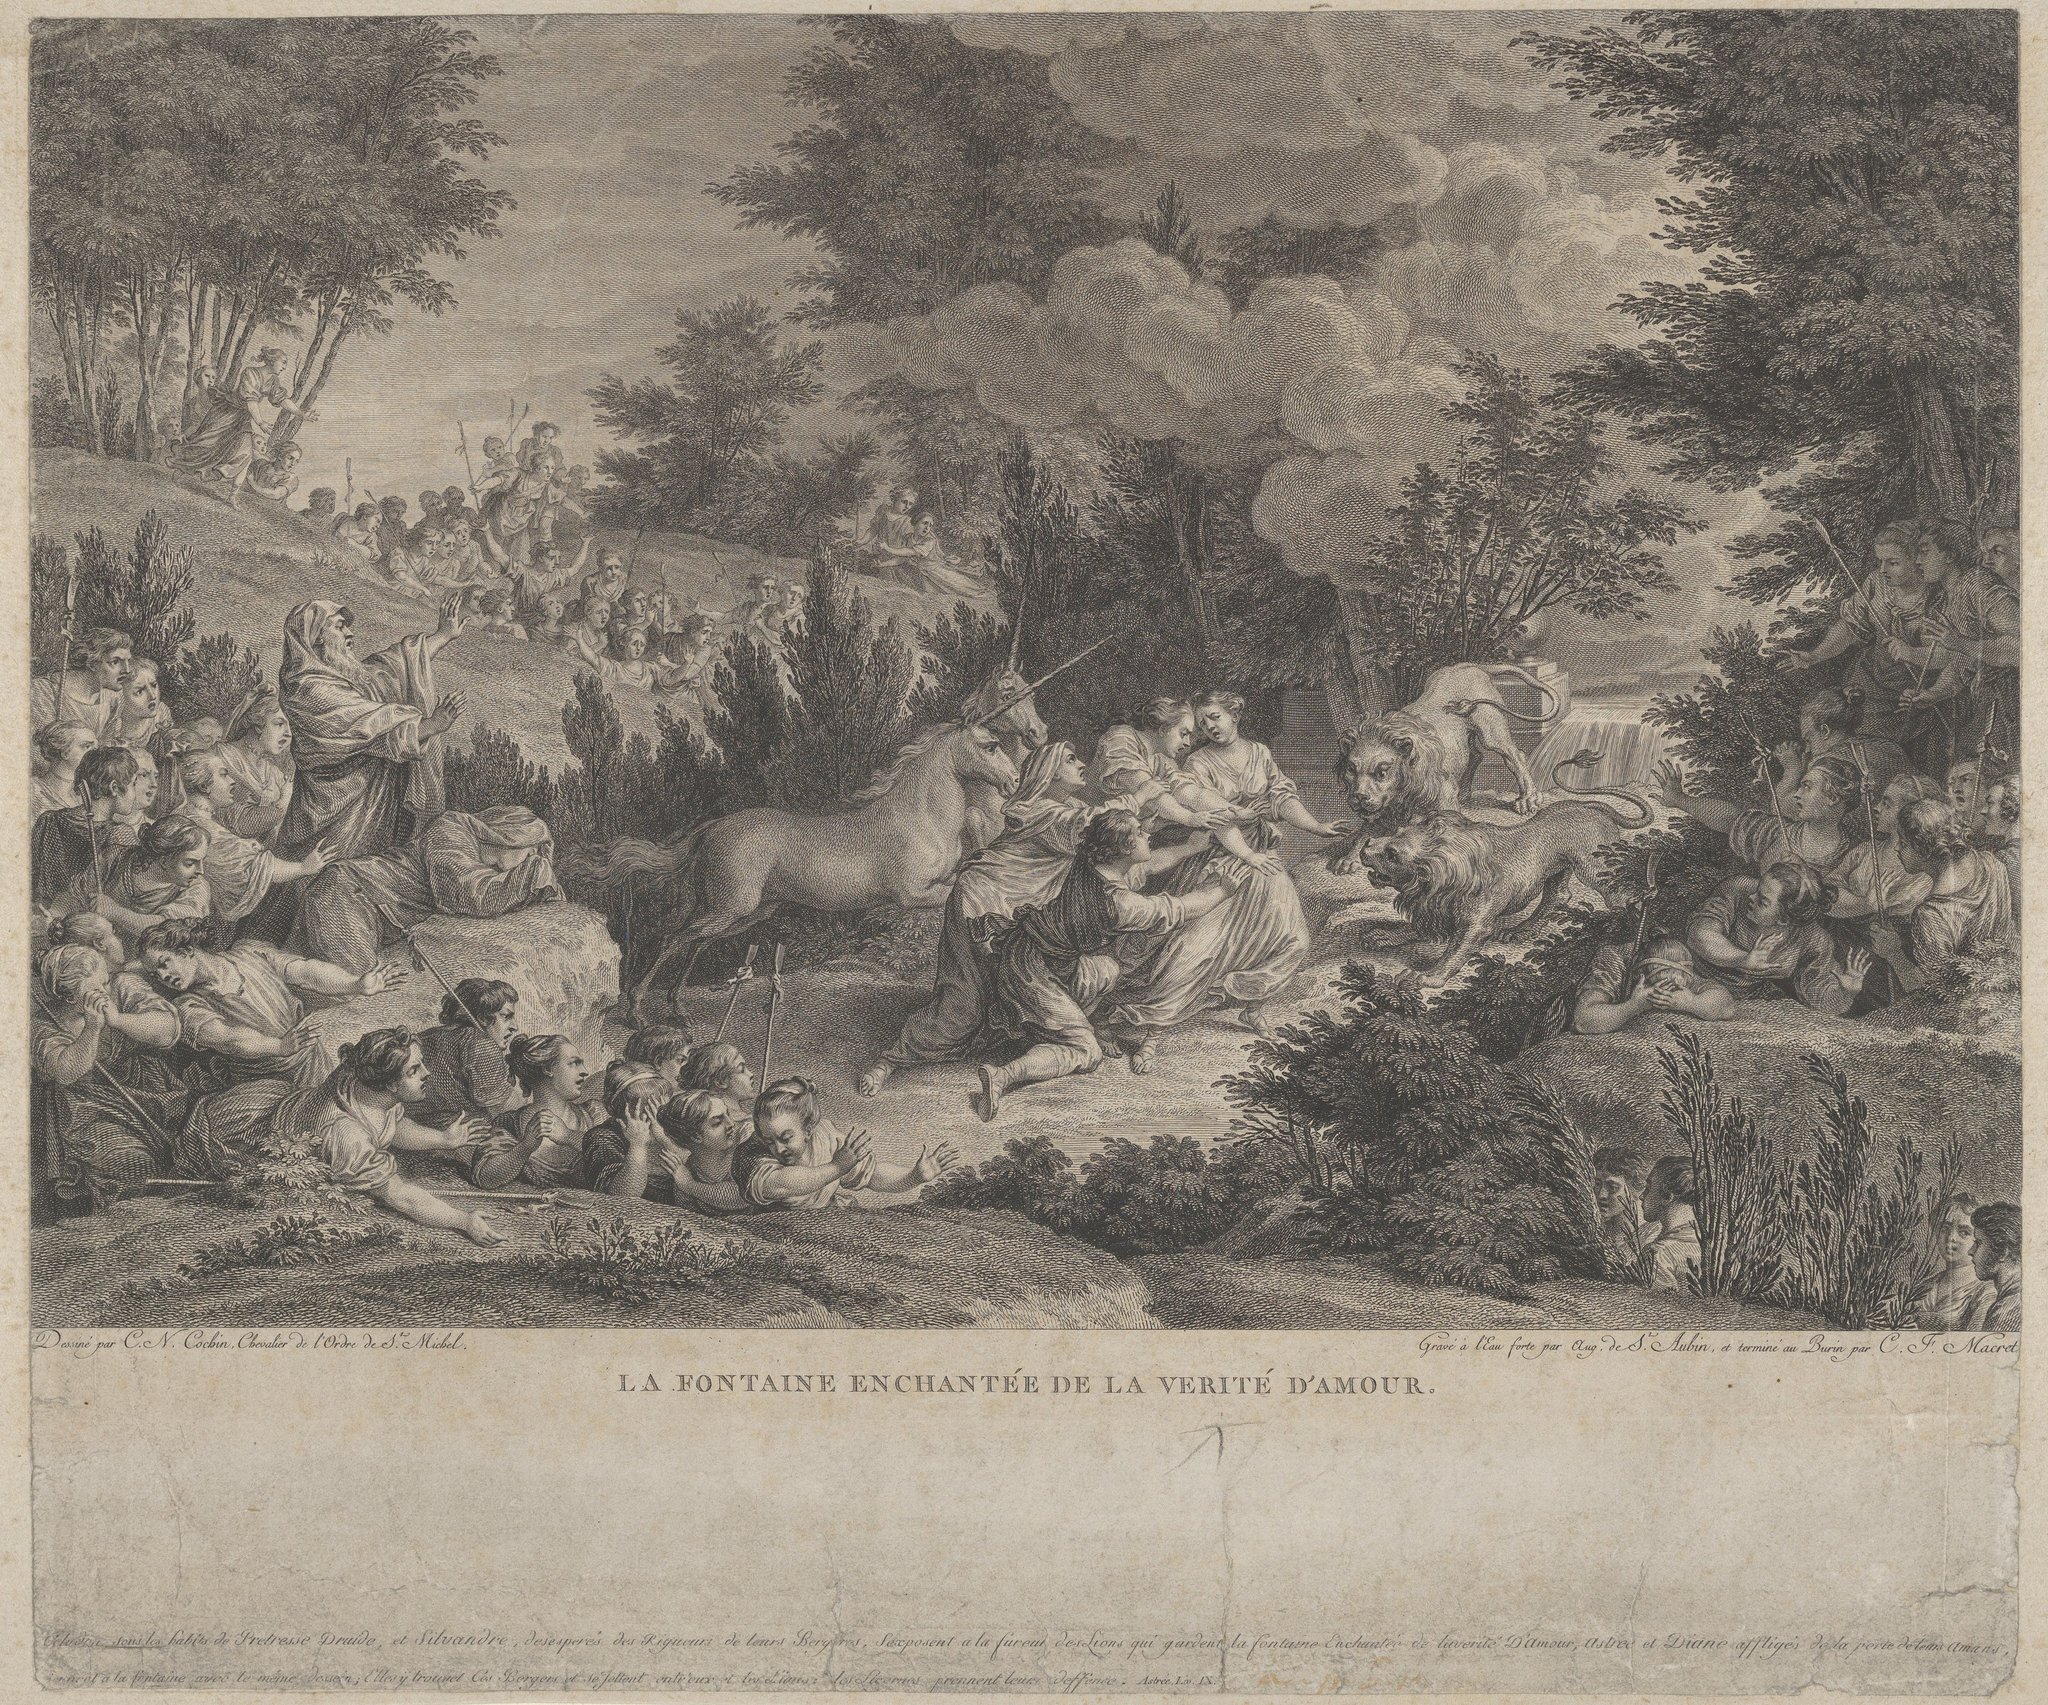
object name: print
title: The Enchanted Fountain of Love's Truth (La Fontaine Enchantée de la Verité d'Amour)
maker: augustin de saint-aubin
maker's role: etcher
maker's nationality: french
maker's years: 1736-1807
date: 1783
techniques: engraving, etching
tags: fear,men,women,unicorns,lions,crowd